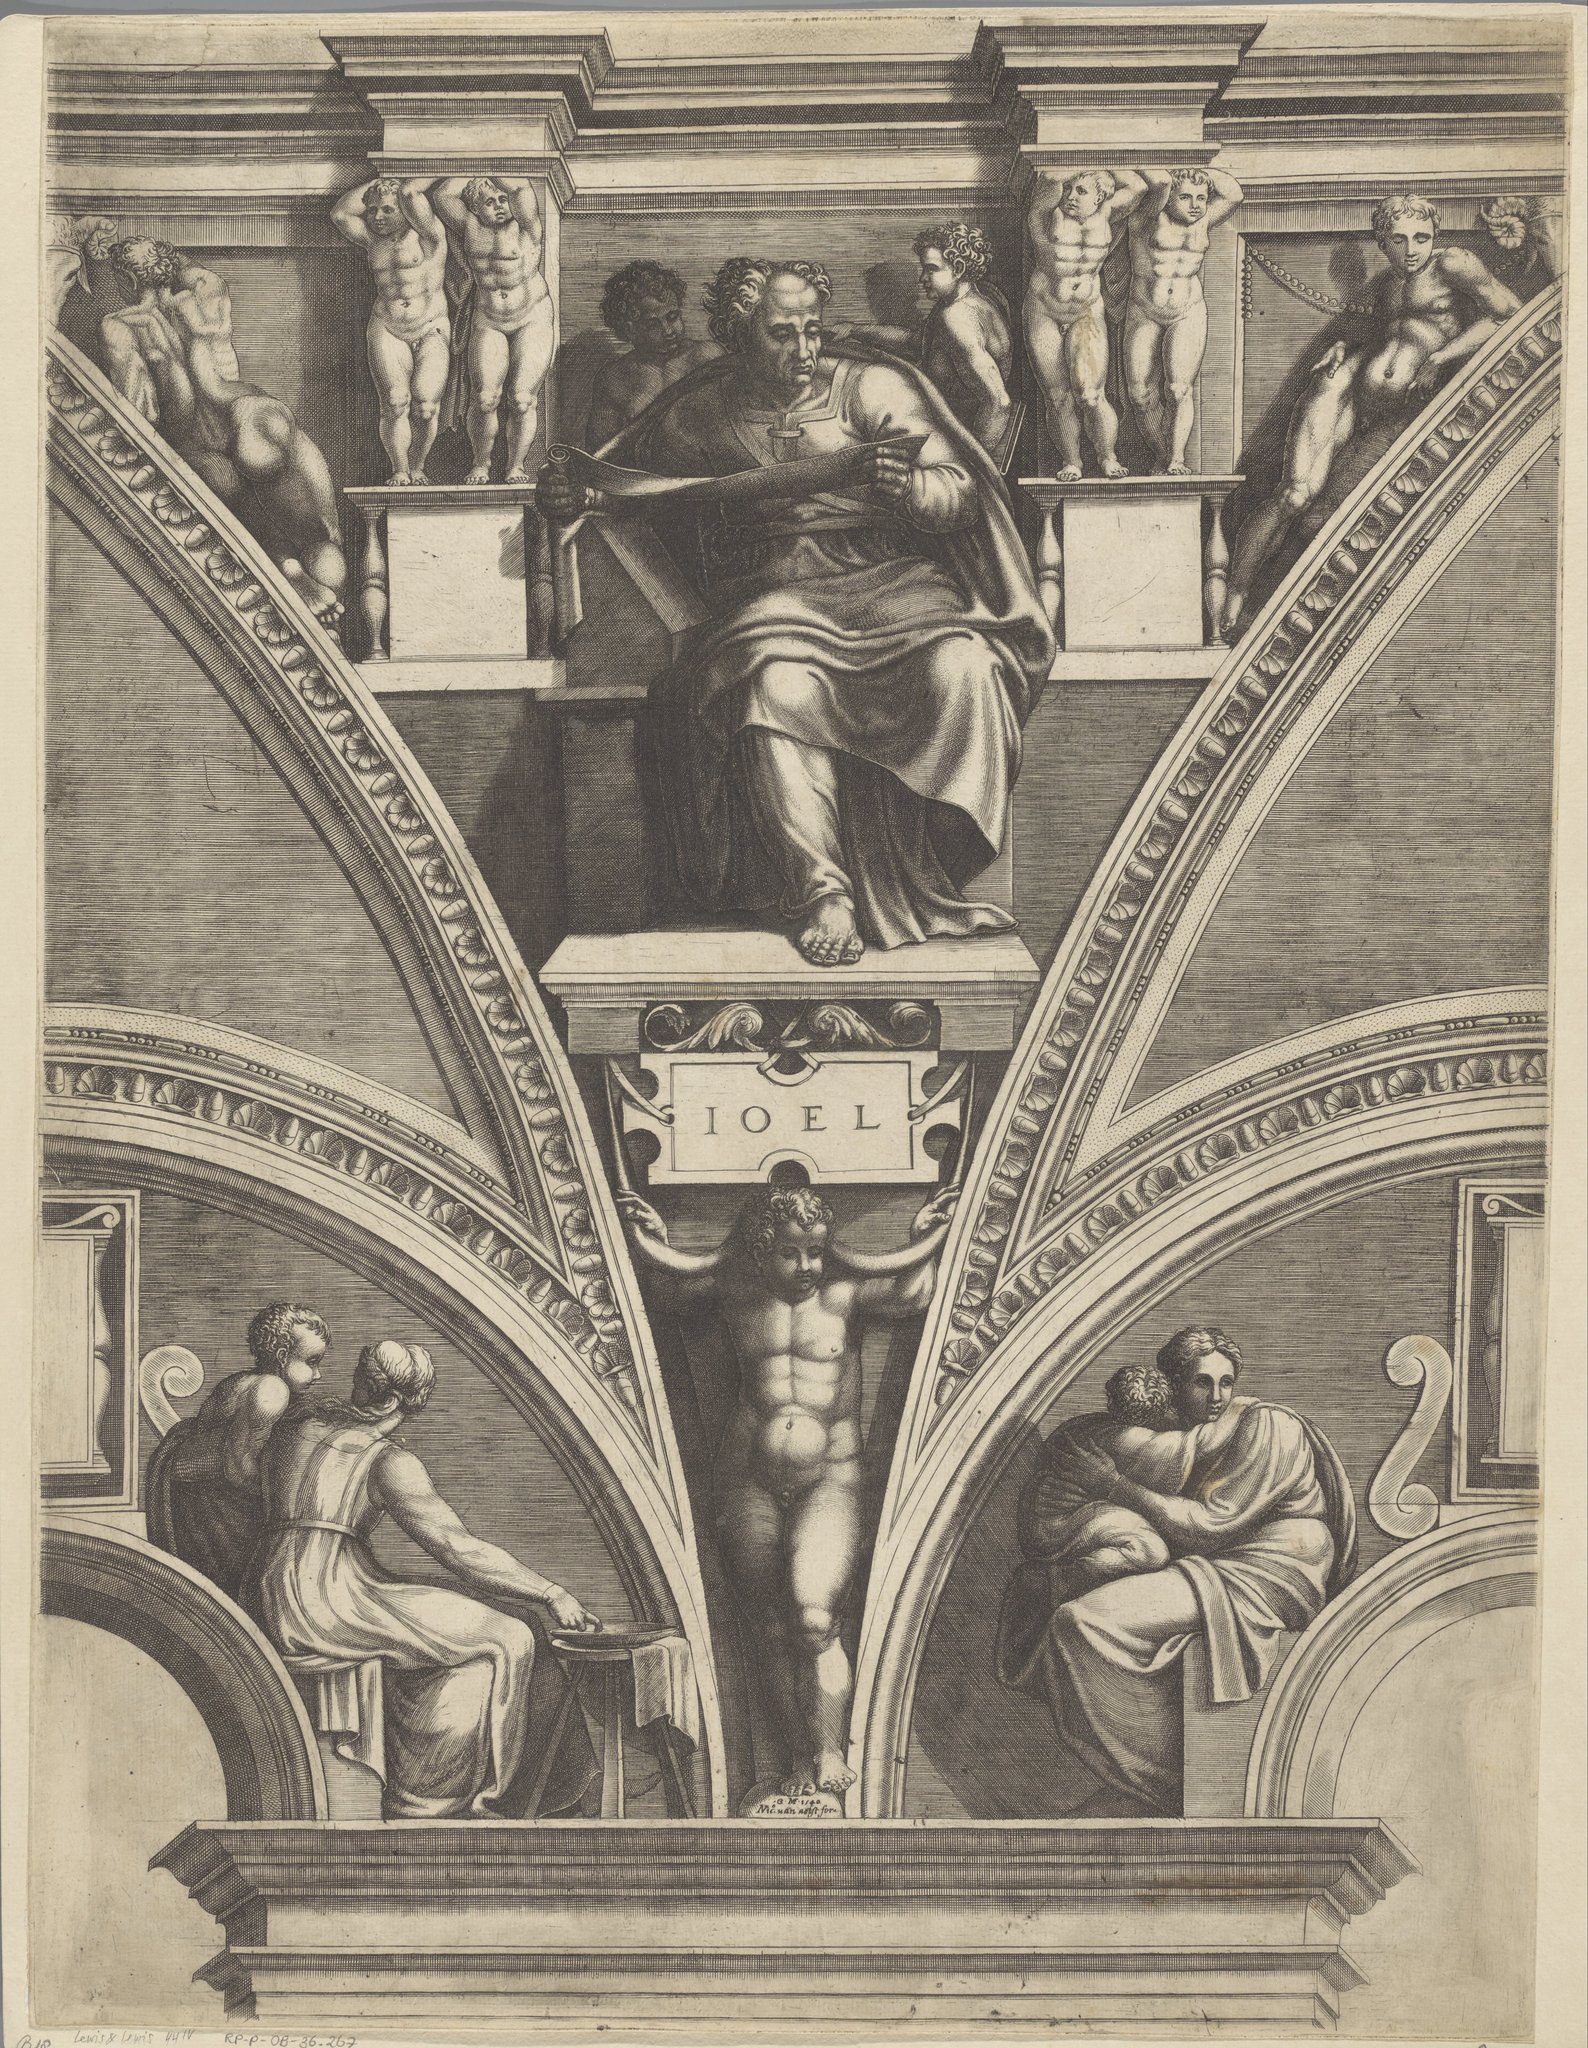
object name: print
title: Schilderingen in de lunetten boven de ramen in de Sixtijnse Kapel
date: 1540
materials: paper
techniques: engraving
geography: vatican city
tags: the book of joel, prophets (after the babylonian captivity)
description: Prent uit een reeks van 6 prenten naar de schilderingen in de lunetten boven de ramen in de Sixtijnse Kapel door Michelangelo.